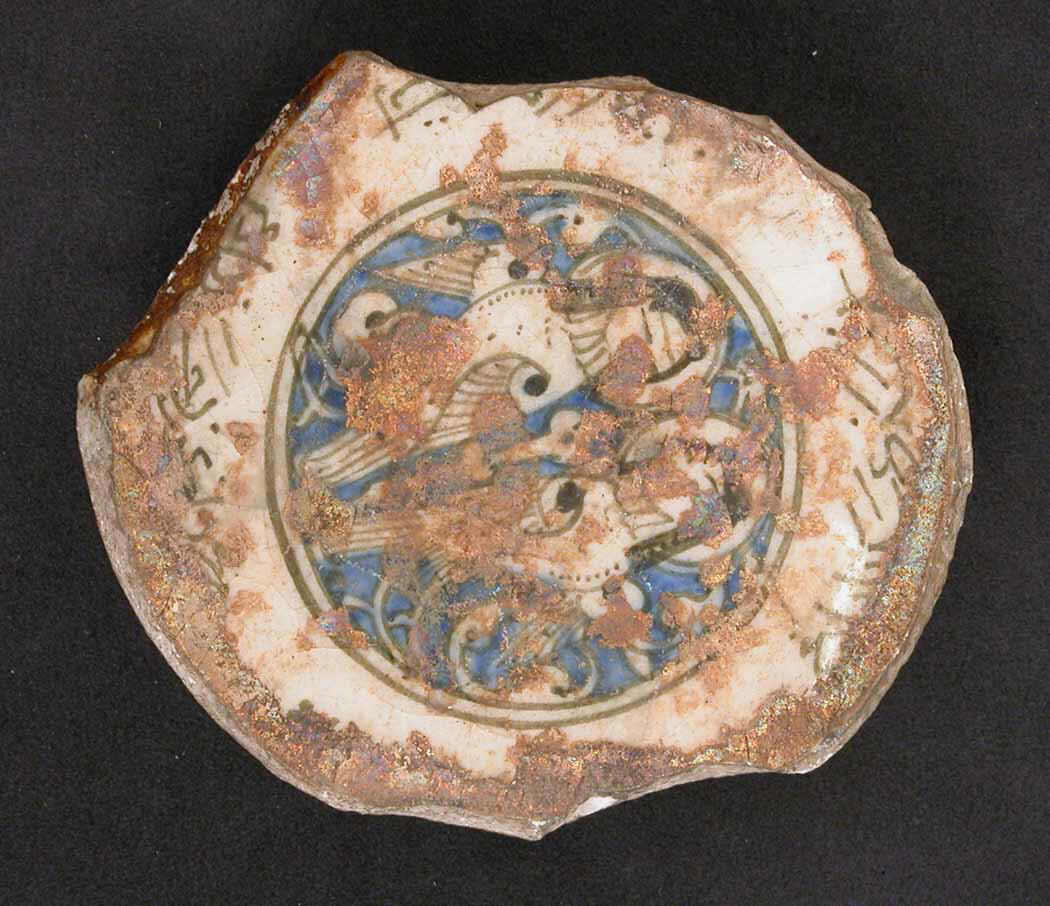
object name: fragment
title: Fragment of a Bowl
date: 1101-1300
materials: stonepaste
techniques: painting, underglaze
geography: iran